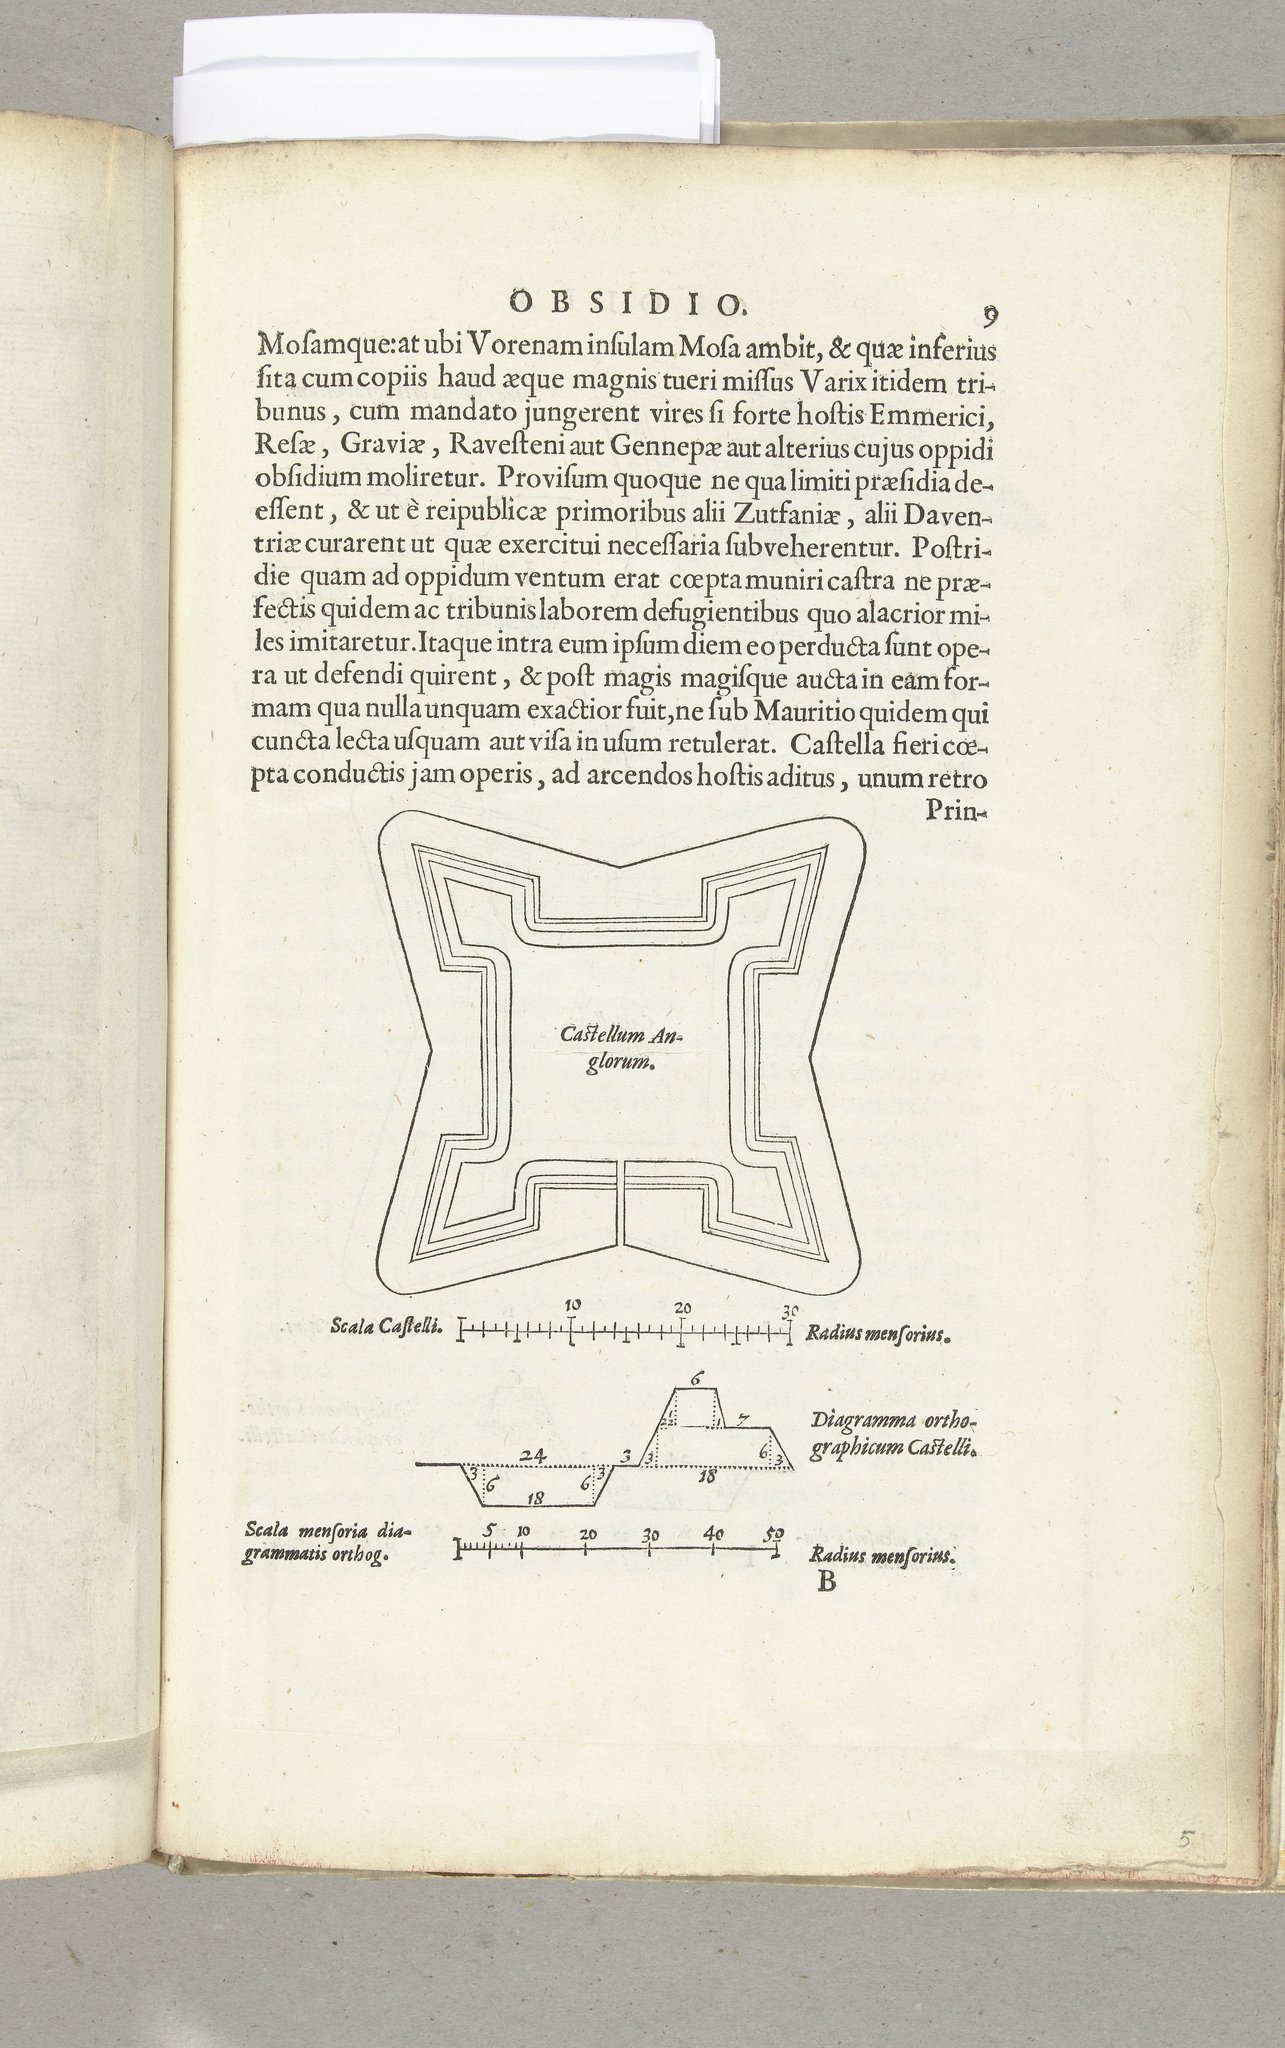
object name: print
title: Plattegrond en doorsnede van een Engels fort tijdens het beleg van Bergen op Zoom, 1622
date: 1627-1629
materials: paper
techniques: woodcut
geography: northern netherlands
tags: fortress, bergen op zoom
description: Tekstillustratie met een plattegrond en doorsnede van een Engels fort tijdens het mislukte beleg van Bergen op Zoom door het Spaanse leger onder Spinola en Velasco, 18 juli - 3 oktober 1622. Onderdeel van de platen bij het verslag van het beleg en de verovering van Grol door het Staatse Leger onder Frederik Hendrik, 6 juli tot 19 augustus 1627.